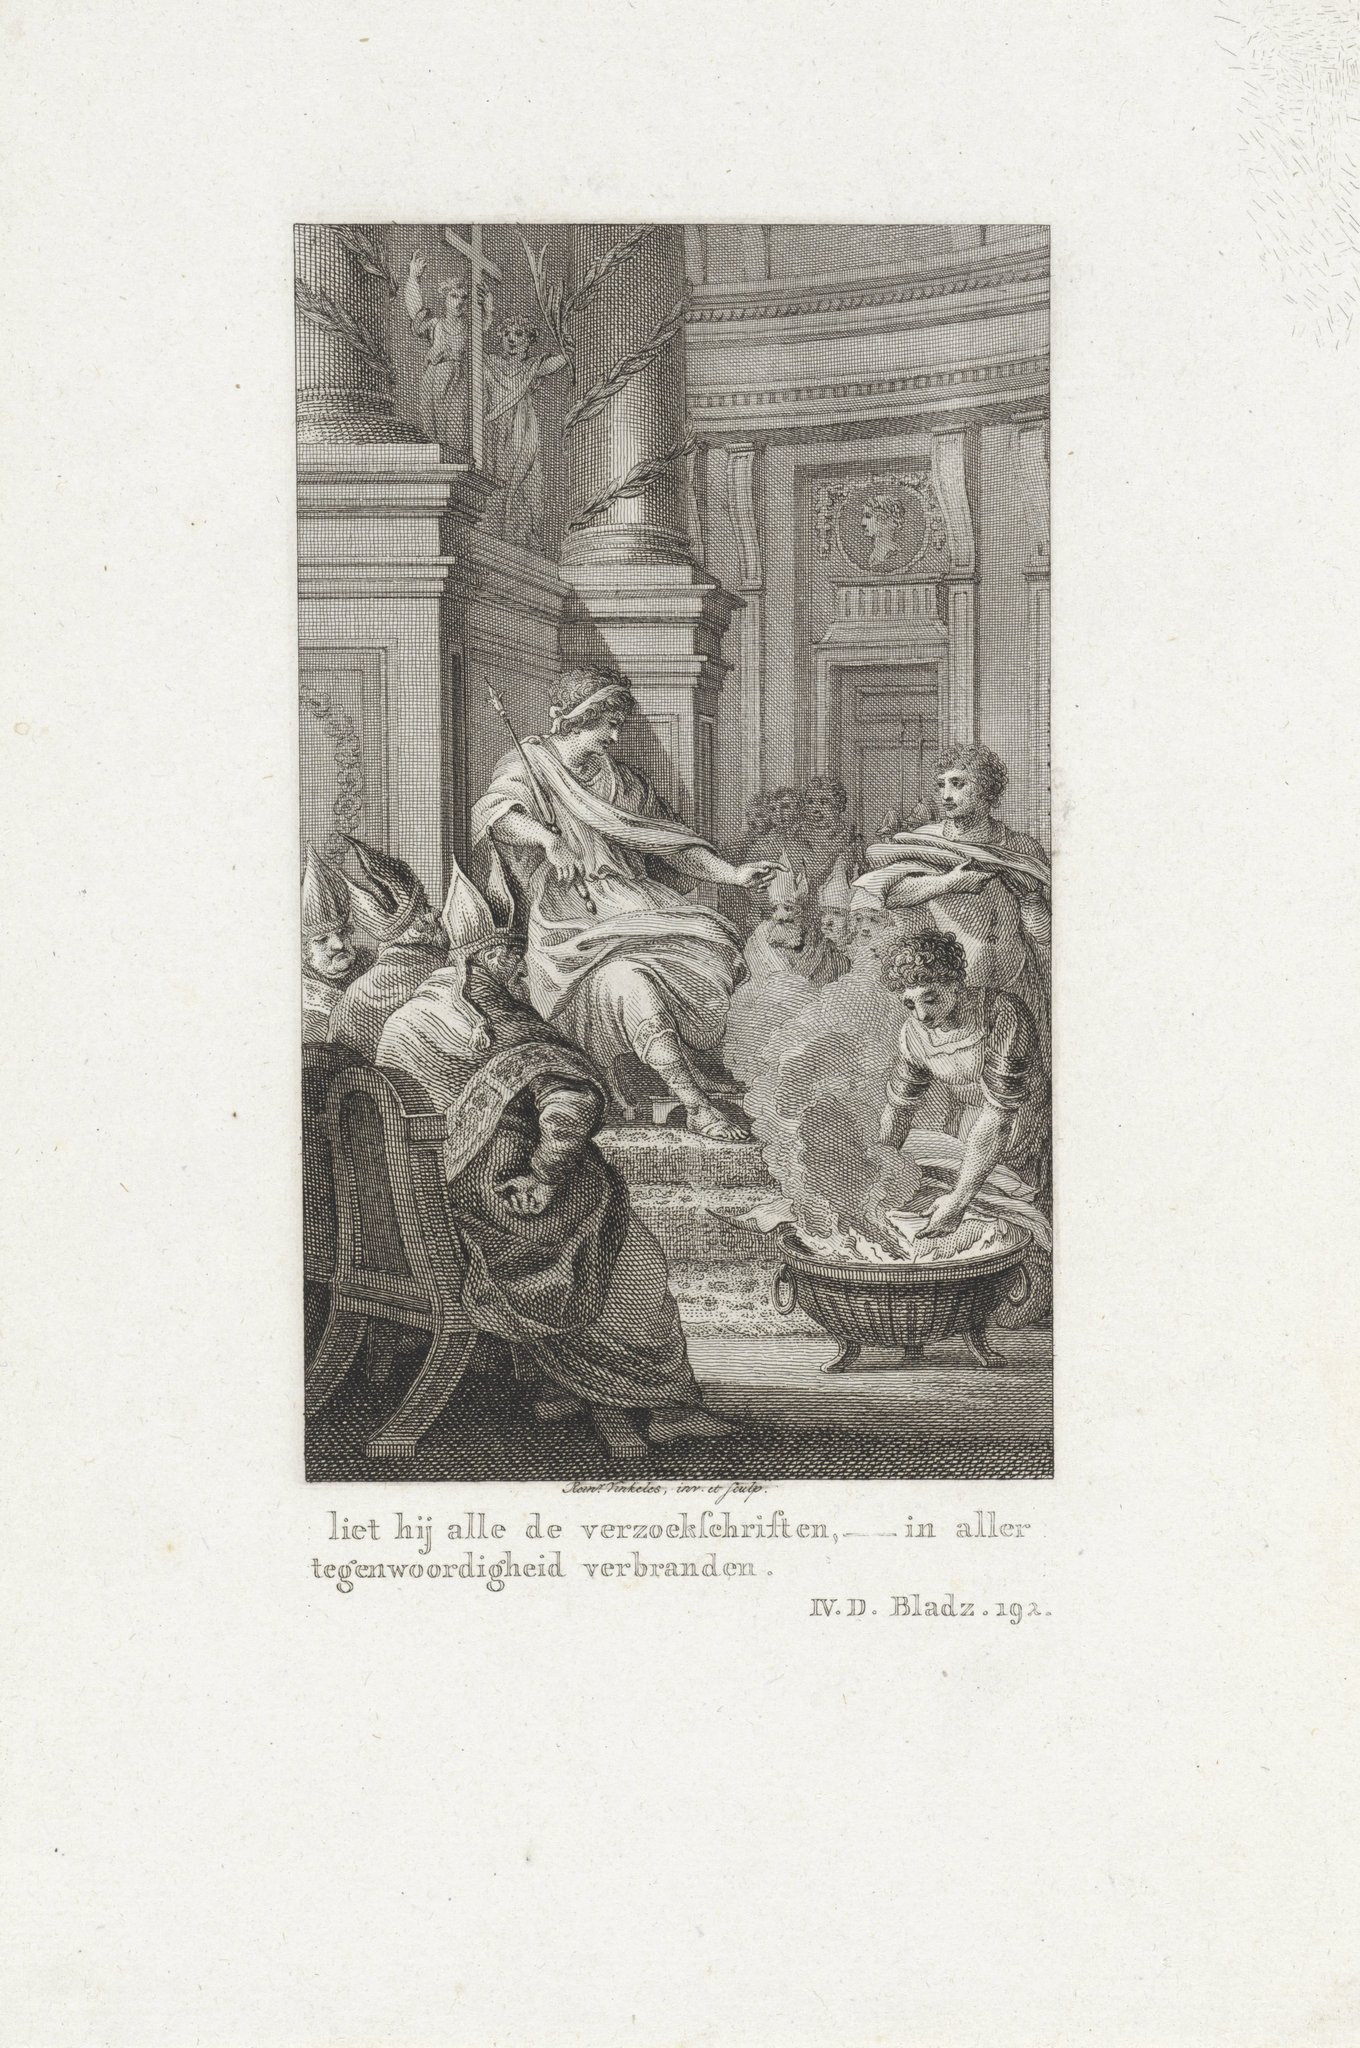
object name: print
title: Constantijn de Grote laat verzoekschriften verbranden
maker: reinier vinkeles (i)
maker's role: draughtsman, print maker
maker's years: 1741-1816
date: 1801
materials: paper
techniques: engraving, etching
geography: amsterdam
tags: archbishop, bishop, etc. (roman catholic), letter, envelope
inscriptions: collector's mark: Lugt 240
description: Tijdens een vergadering met de bisschoppen laat keizer Constantijn al hun klachtenbrieven en verzoekschriften verbranden om eendracht en vrede in de kerk te stimuleren.